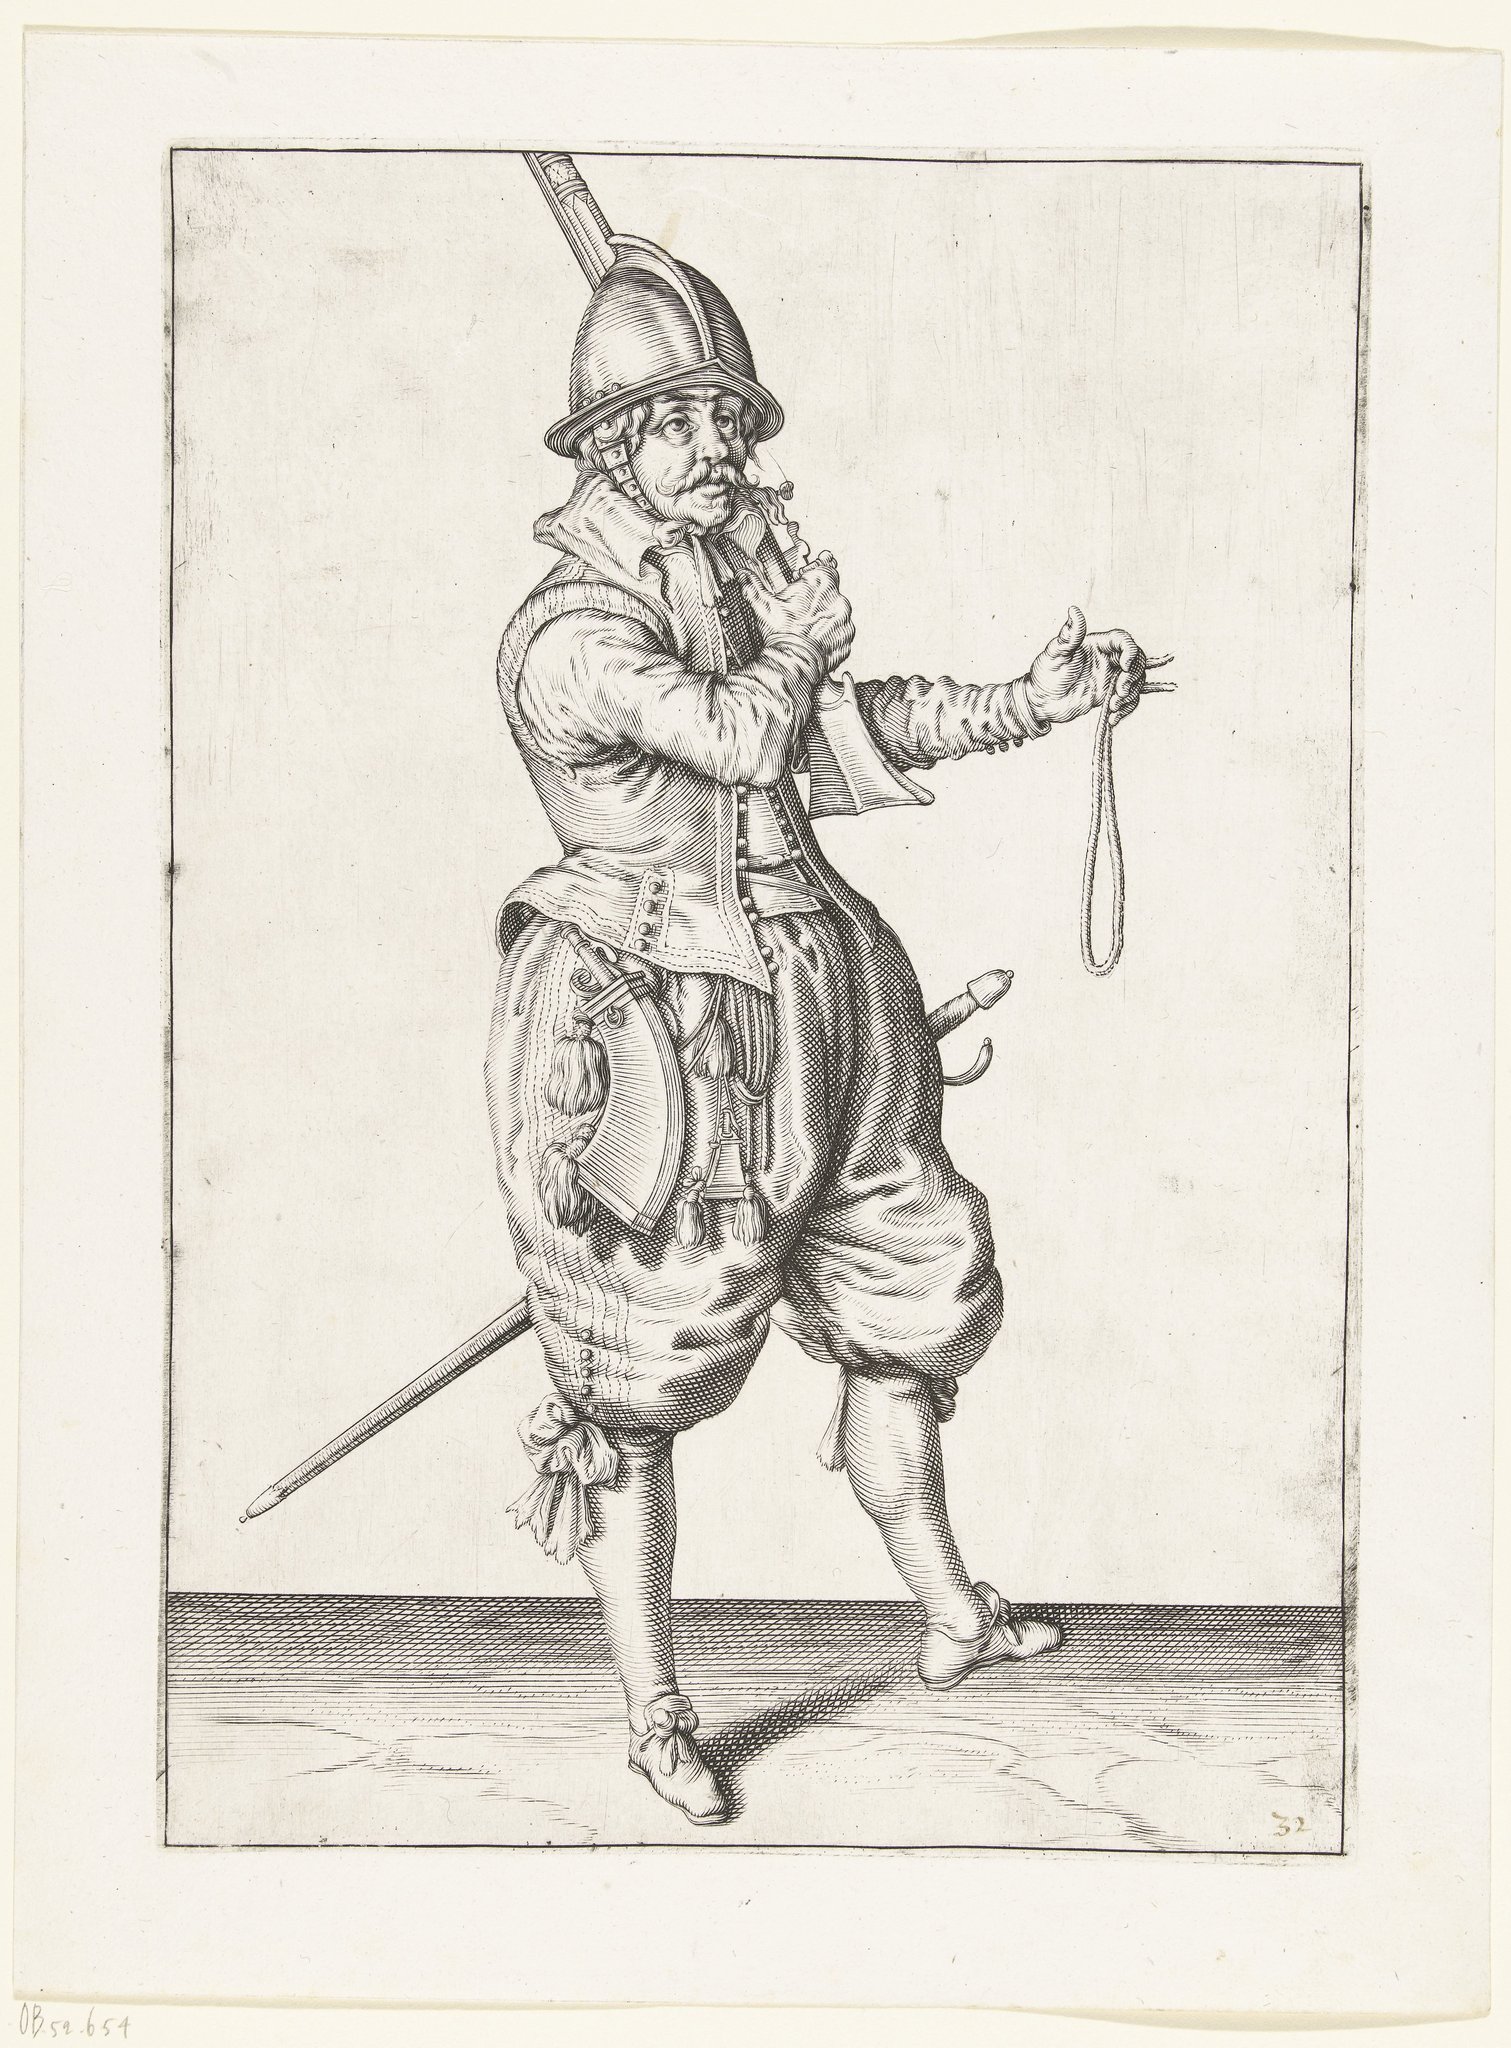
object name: print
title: Soldaat die zijn roer met zijn rechterhand op zijn schouder legt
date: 1597-1607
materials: paper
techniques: engraving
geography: netherlands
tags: manoeuvre ~ military training, firearms: rifle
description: Een soldaat, ten voeten uit, naar rechts, die een roer (een bepaald type vuurwapen) met zijn rechterhand op zijn linkerschouder legt, de loop omhoog wijzend. In zijn uitgestoken linkerhand een brandende lont - de rook nog niet weergegeven op deze eerste staat. Deze prent is onderdeel van de reeks van 42 genummerde prenten van roerschutters uit de Wapenhandelinghe.